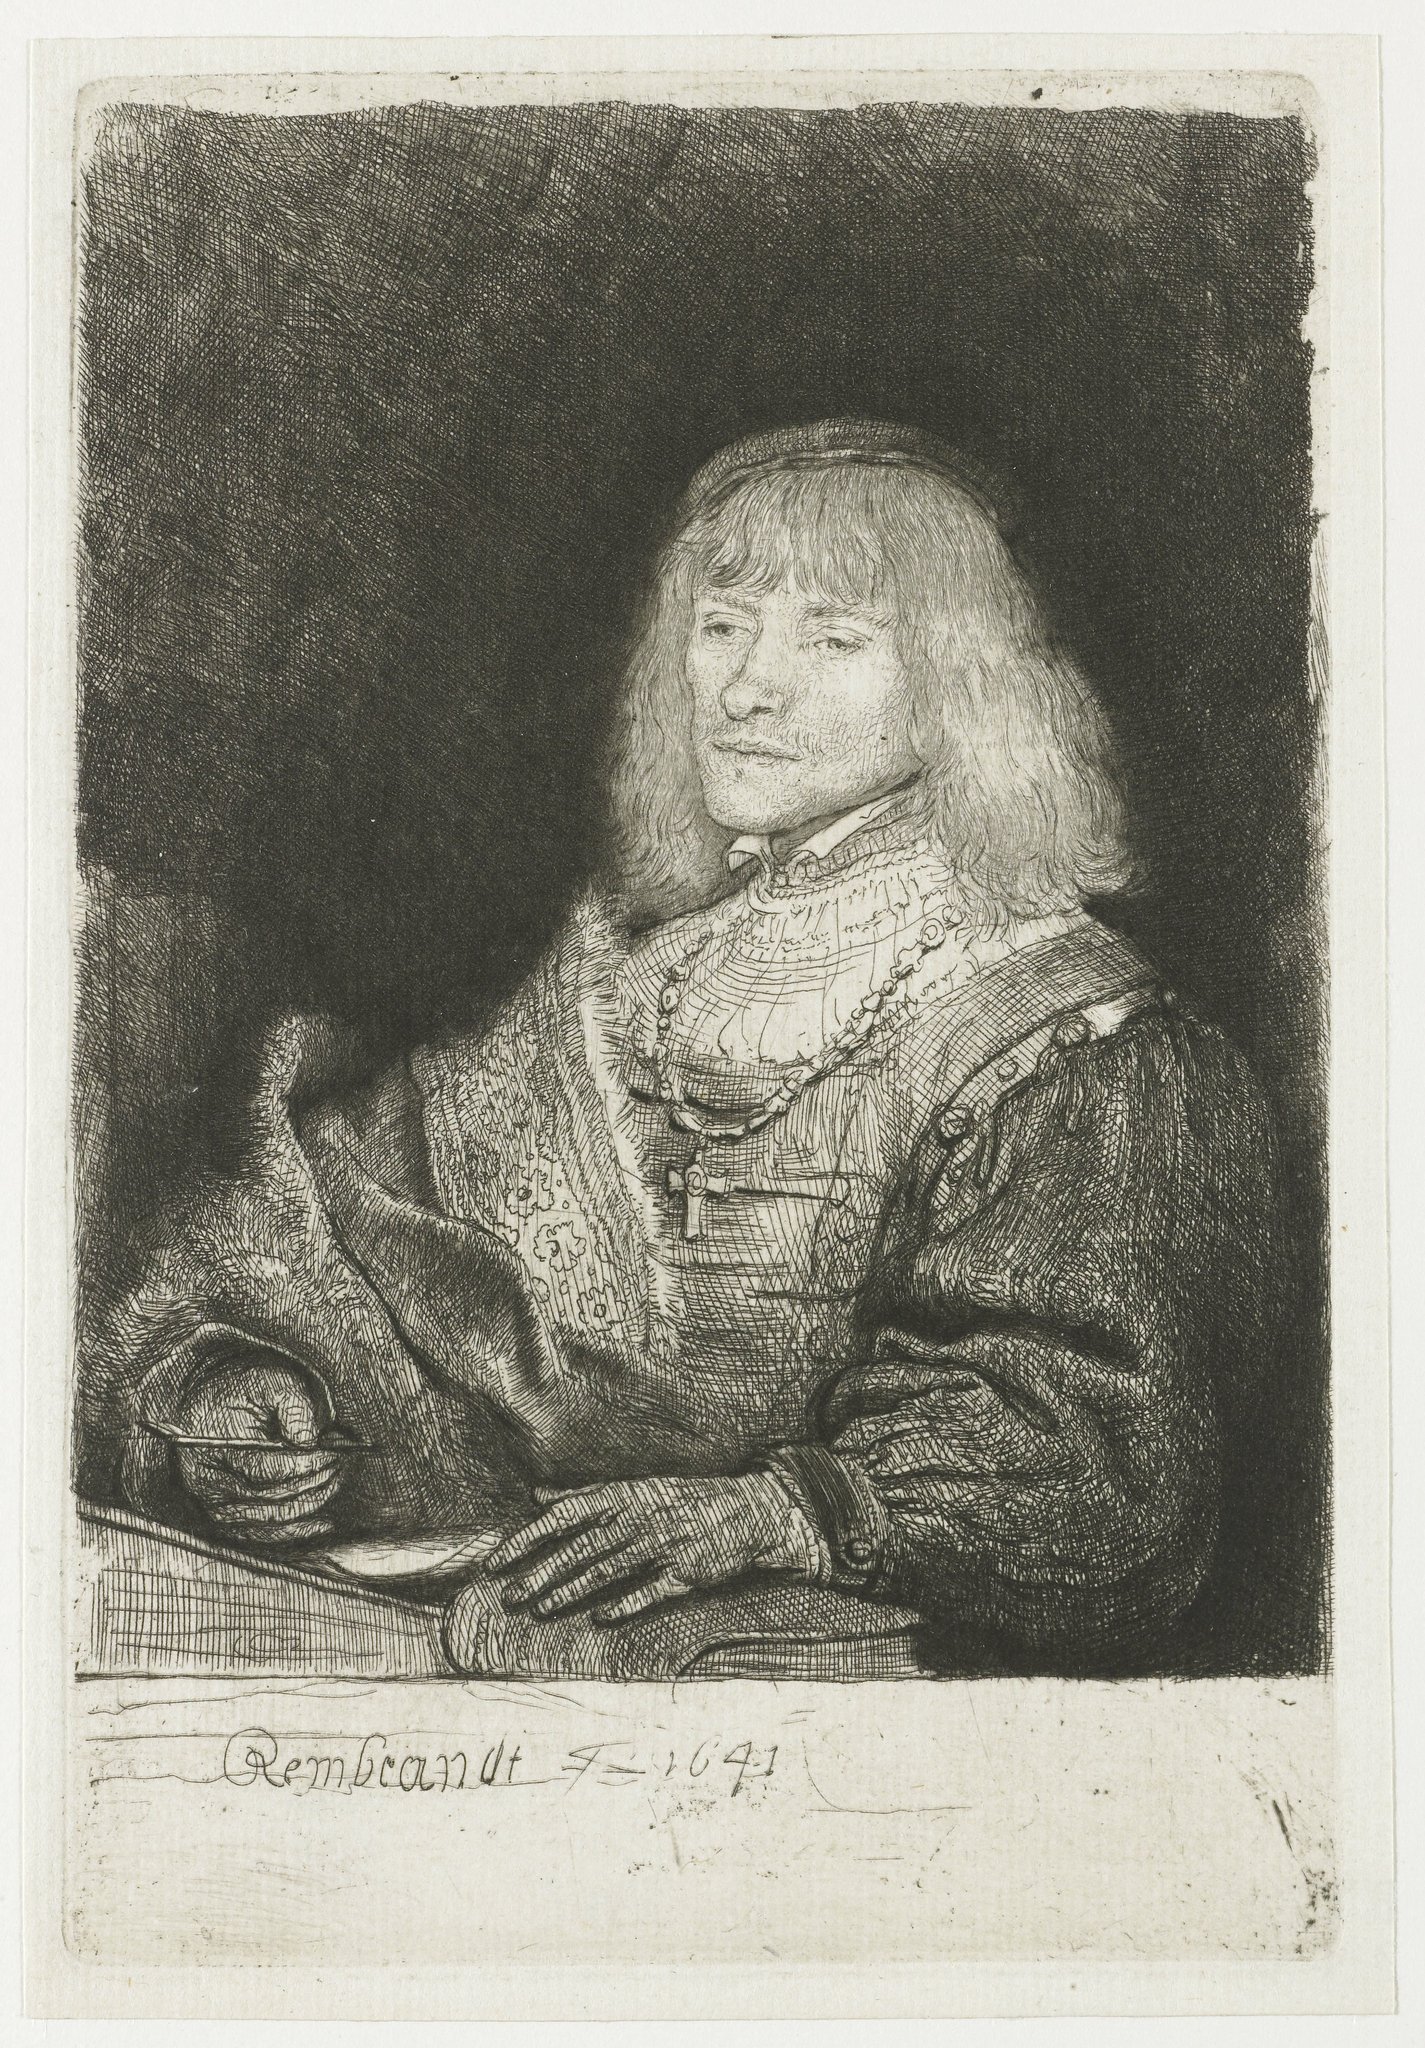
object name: print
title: Man at a desk wearing a cross and chain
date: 1641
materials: paper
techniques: drypoint, etching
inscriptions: mark: Lugt 2165, signature and date: ‘Rembrandt f 1641’